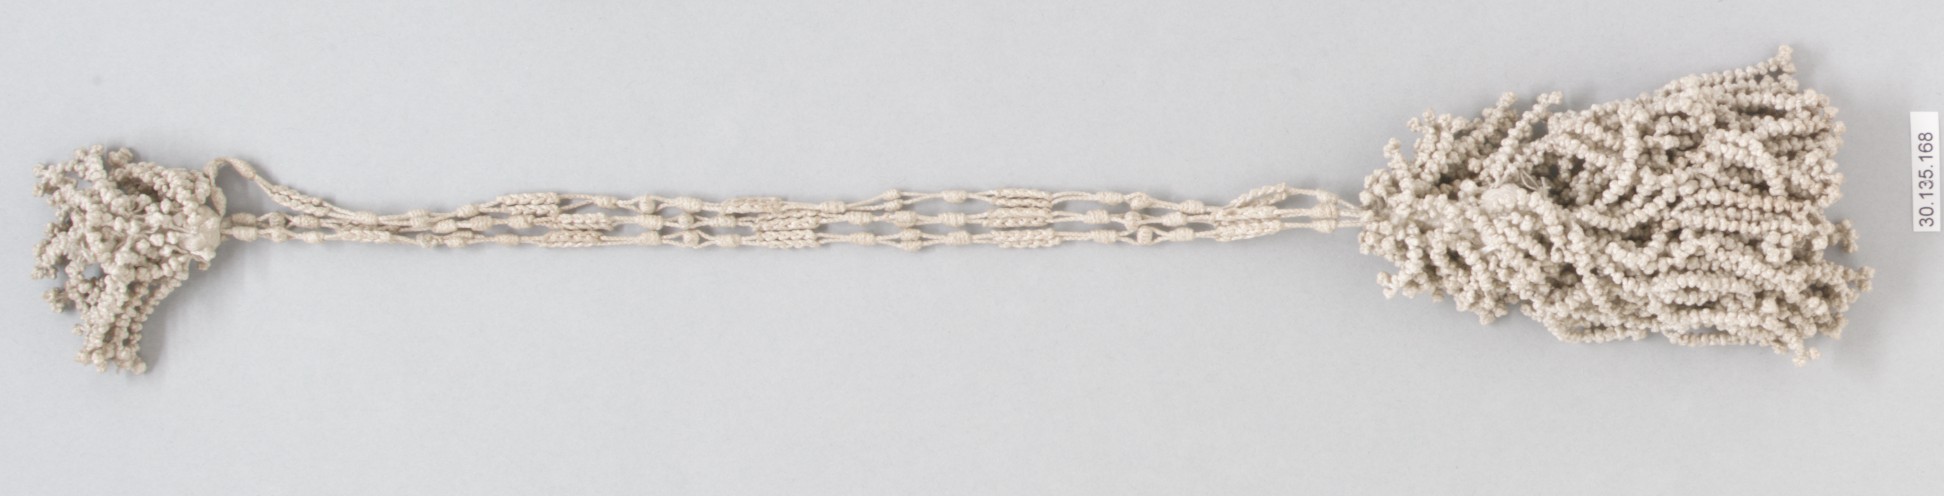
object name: tassel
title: Pair of tassels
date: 1601-1700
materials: linen